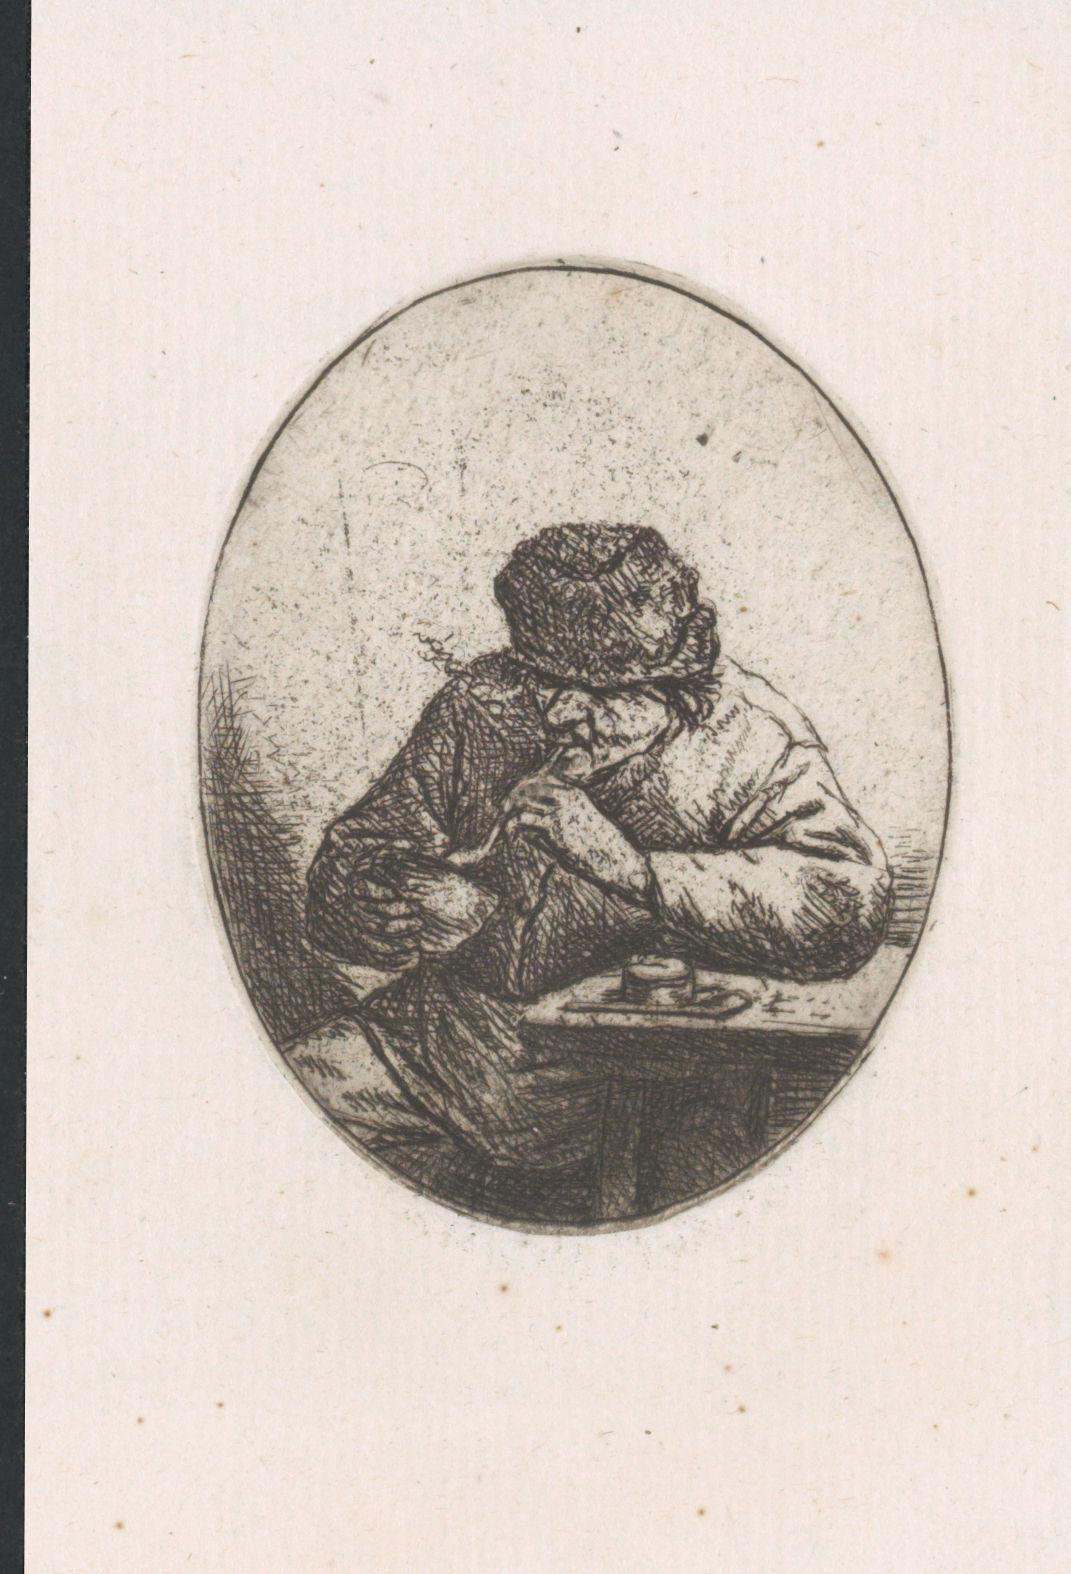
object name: album leaf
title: Buste van een lachende boerin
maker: adriaen van ostade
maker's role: draughtsman, painter, print maker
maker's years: 1610-1685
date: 1650-1652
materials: paper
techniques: etching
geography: haarlem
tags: laughing, head (human) - aa - female human figure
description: Deze prent maakt deel uit van een album.